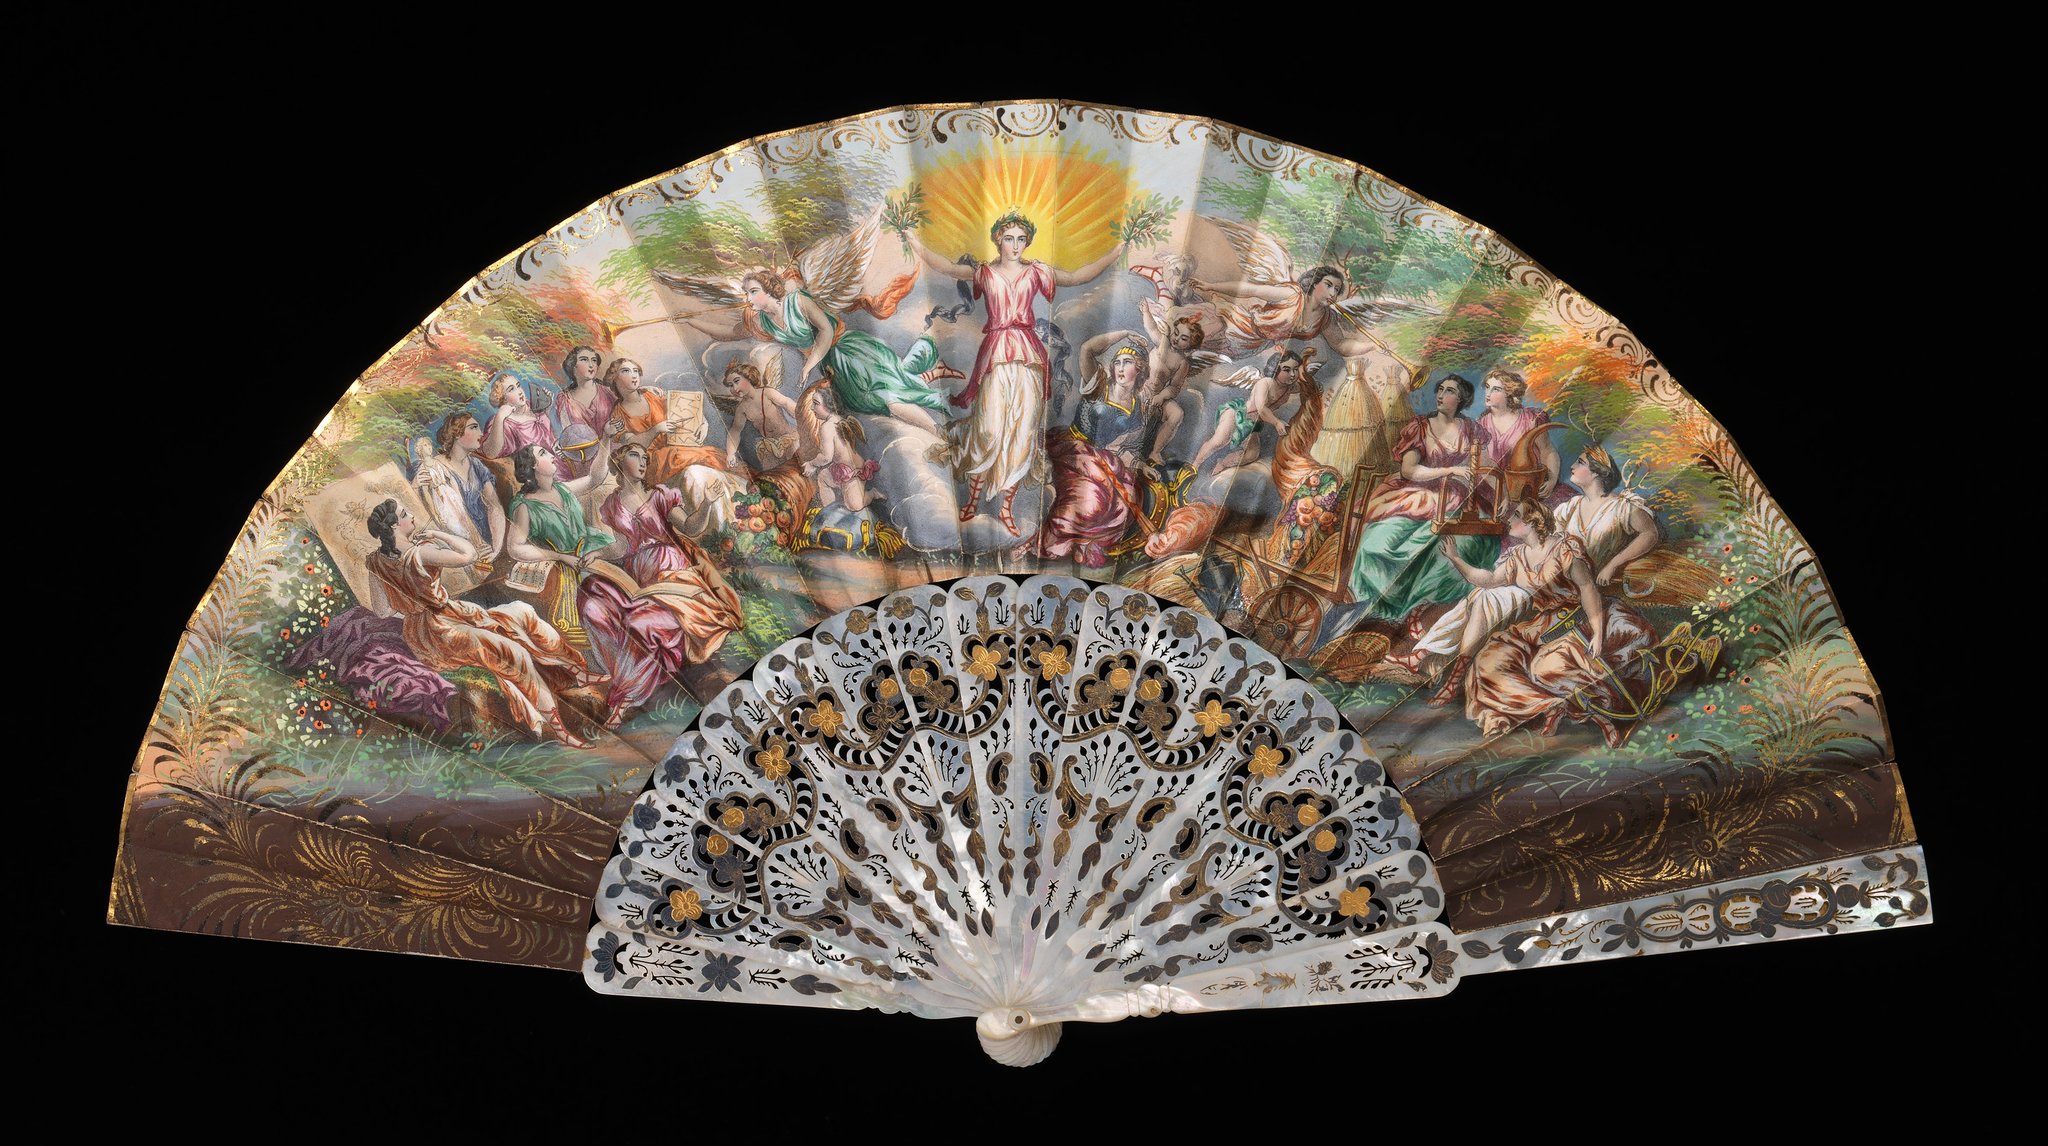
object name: fan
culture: european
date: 1855-1865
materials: metal, mother of pearl, paper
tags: musical instruments,women